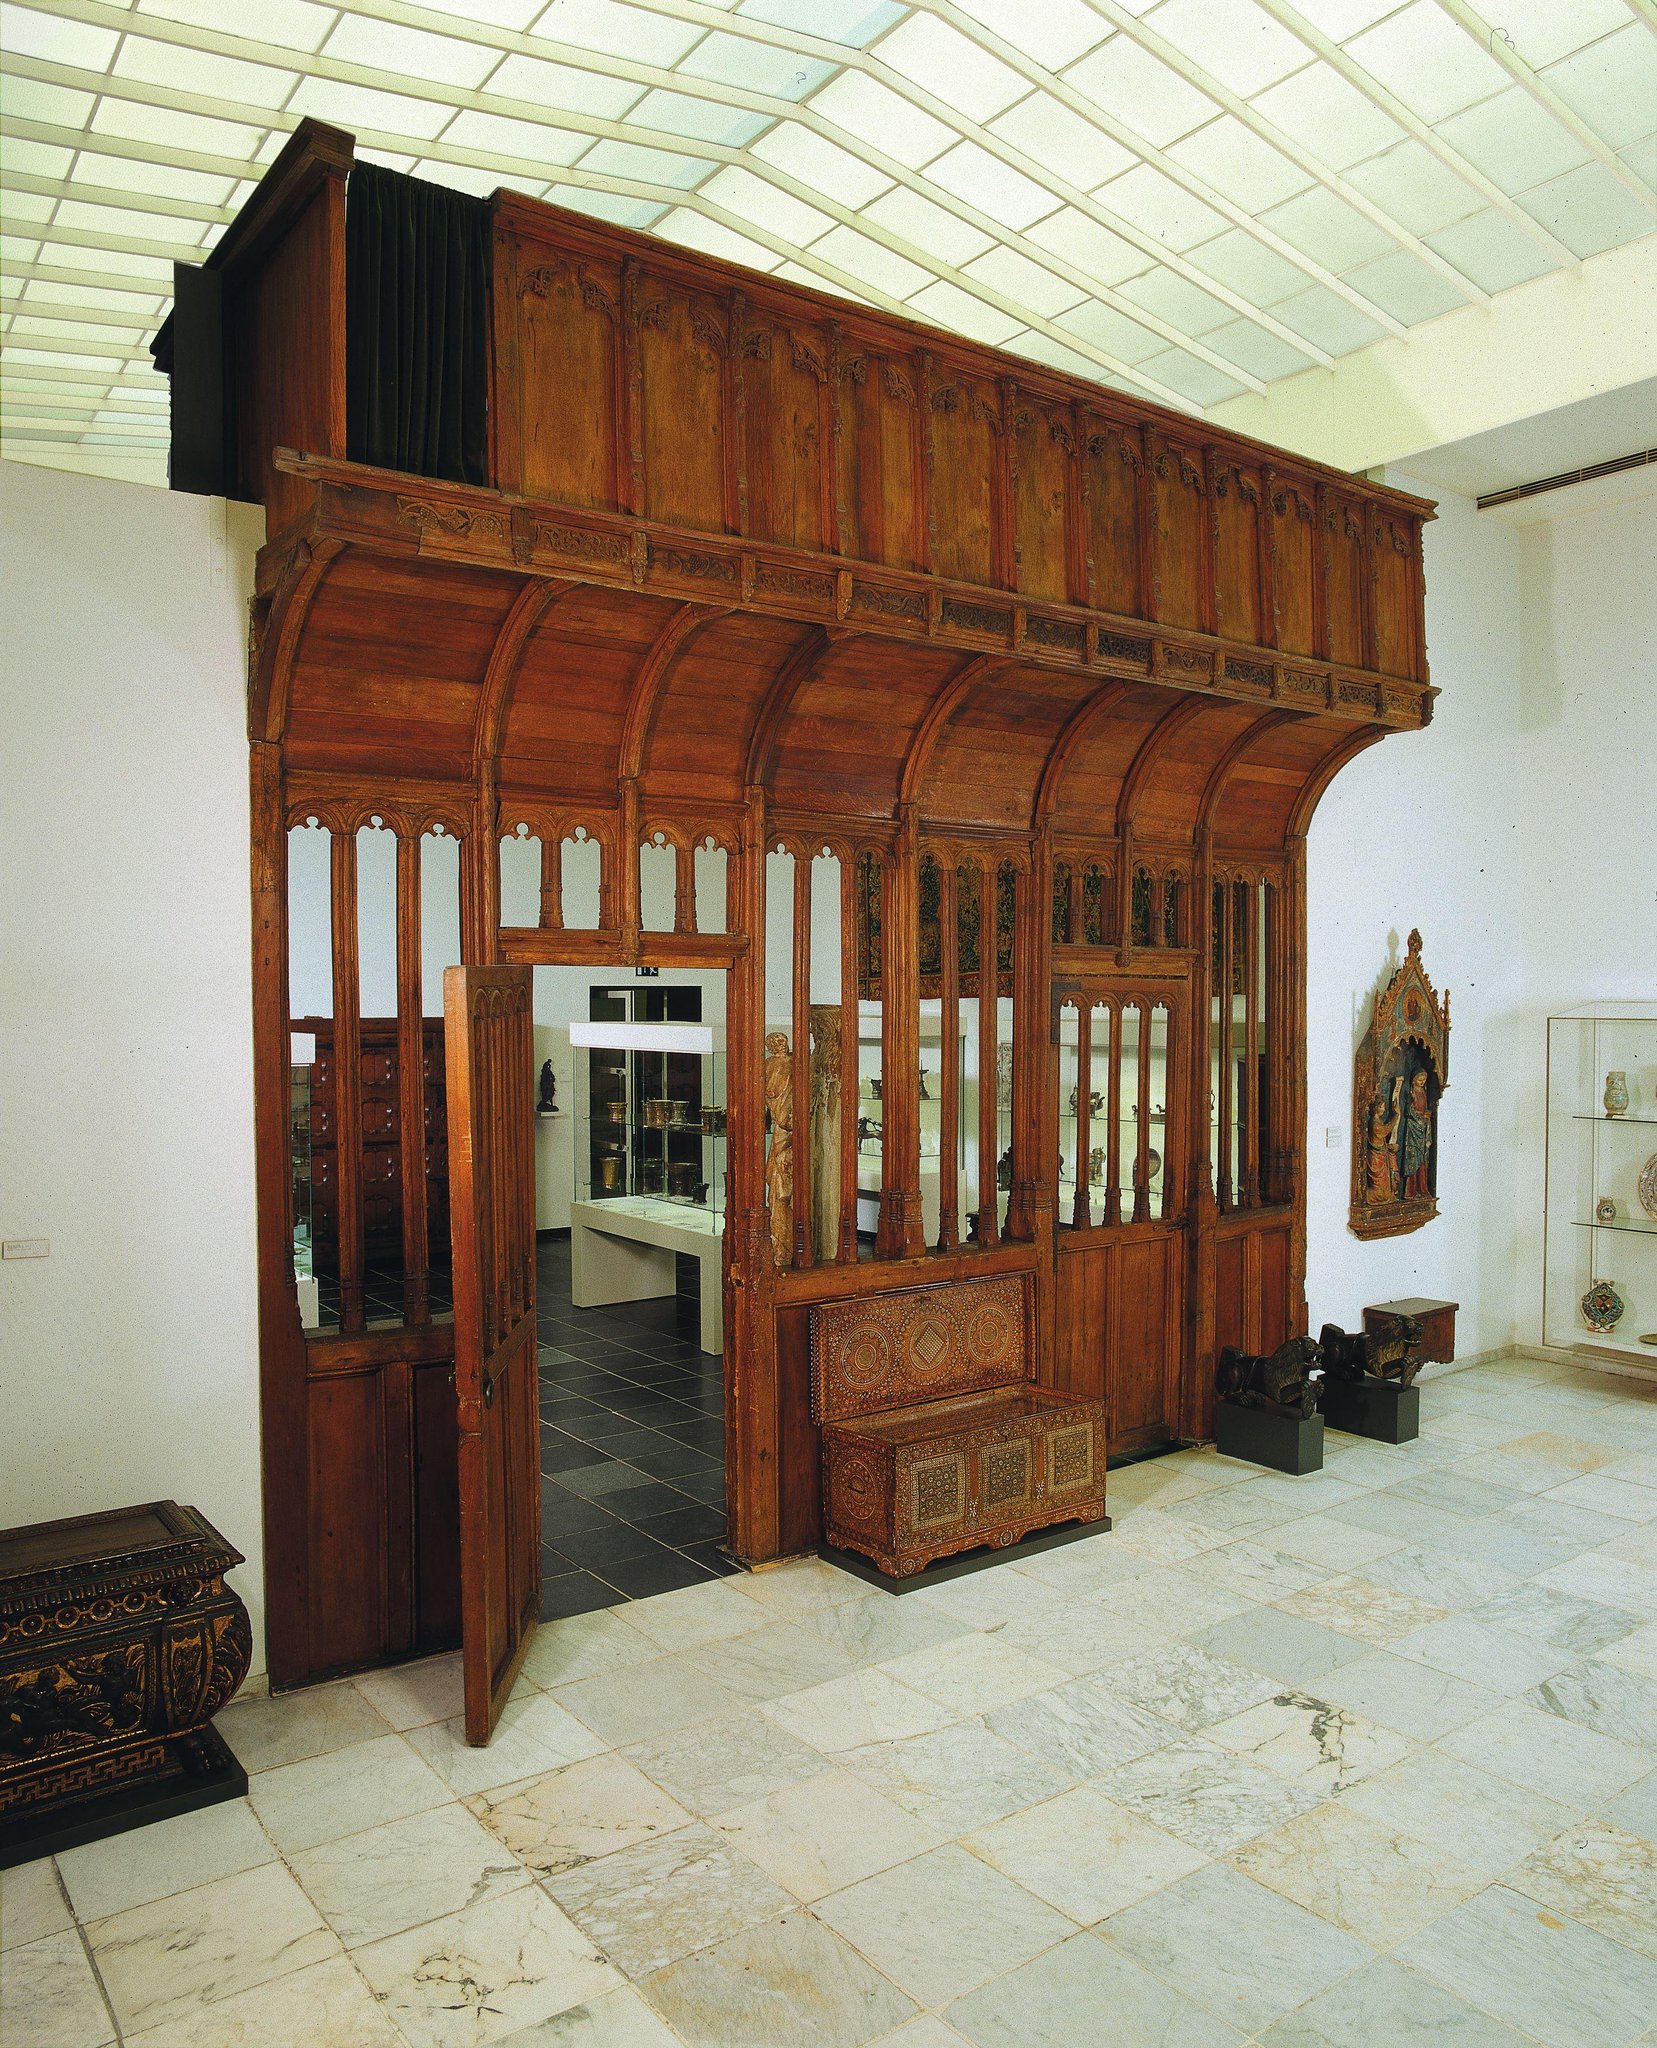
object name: rood loft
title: Oksaal (koorafscheiding), afkomstig uit de kerk te Helvoirt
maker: Anonymous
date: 1500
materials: wood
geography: netherlands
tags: ornament ~ tracery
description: Oksaal van eikenhout. Op een stelling van zware stijlen en dorpels (ribhout) staat een dubbele koof, waarop de vloer van de eigenlijke zangerstribune rust. Deze laatste is aan alle zijden door een schot in heuphoogte omgeven. De onderbouw is tot borsthoogte gedicht met gladde panelen, waarboven zware dorpels liggen. Op deze dekbalken staat een hek van smalle stijlen, dat tegen de bovendorpel van de onderbouw in gotische arcaden met traceerwerk afsluit. Twee vakken van de onderbouw draaien als deuren, hun kozijndorpels liggen echter onder de bovendorpel van het geheel. In de voortzetting van de stijlen van de onderbouw rijzen de schenkels van de dubbele koof. De balie der zangerstribune wordt aan de ééne lange zijde (naar het schip der kerk toegekeerd) door pinakels verdeeld in tien panelen, die met Tudorbogen versierd zijn en vijf aan vijf ter weerszijden staan van een in drie zijden van de zeshoek uitgebouwde erker. De bogen zijn in de hoek gevuld met opengewerkte gotische traceringen. De erker heeft onderaan een vrijhangend druipergewelf. Een krachtig geprofileerde lijst scheidt balie en koof. Onder aan deze lijst is een fries met opgelegde, opengewerkte ranken aangebracht, die worden afgewisseld door de druipers, waarin de pinakels der balie eindigen. Uit de voetlijst van het tribuneschot ontwikkelt zich in het midden van ieder paneel een lage console, waarop heiligenfiguren stonden. De andere lange kant van het tribuneschot heeft geen erker en is over het geheel eenvoudiger behandeld. Tussen de pinakels staan daar vlak georneerde gotische bogen. De smalle zijden zijn gedeeltelijk als de voorzijde behandeld. De deuren draaien op zware hengsels. Alle stijlen en dorpels zijn met "visbek" vergaard.